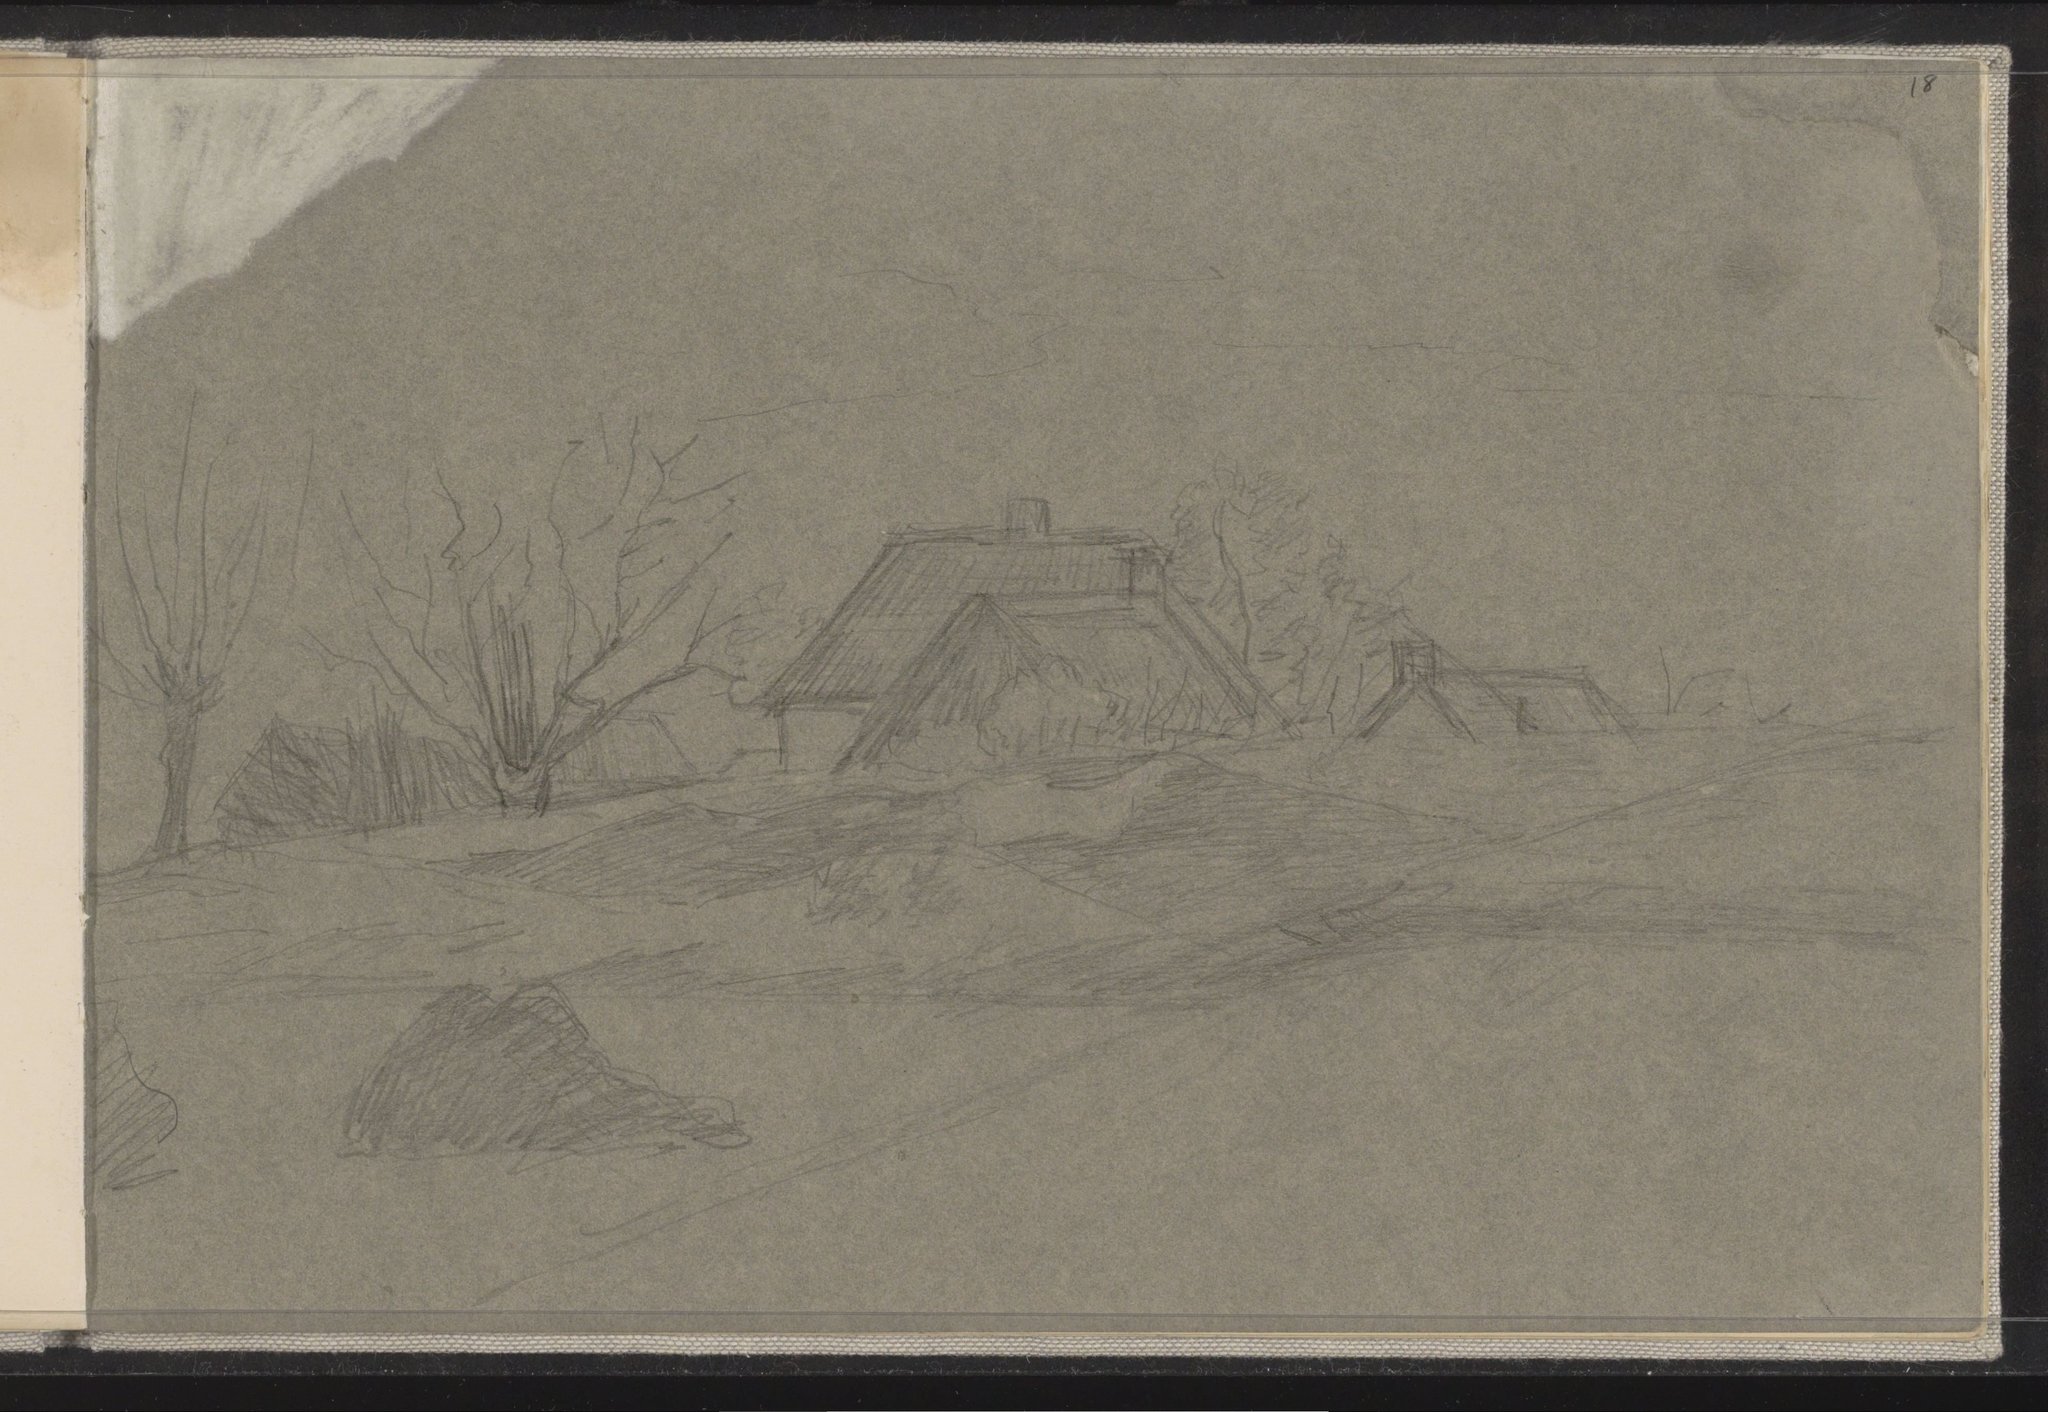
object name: sketchbook leaf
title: Hooioppers op een veld voor een boerderij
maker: jozef israëls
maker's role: draughtsman, painter, print maker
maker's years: 1824-1911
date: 1834-1911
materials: paper, pencil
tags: hay-stack, farm (building)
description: Op de achtergrond ook knotwilgen. Blad 18 recto uit een schetsboek met 30 bladen.